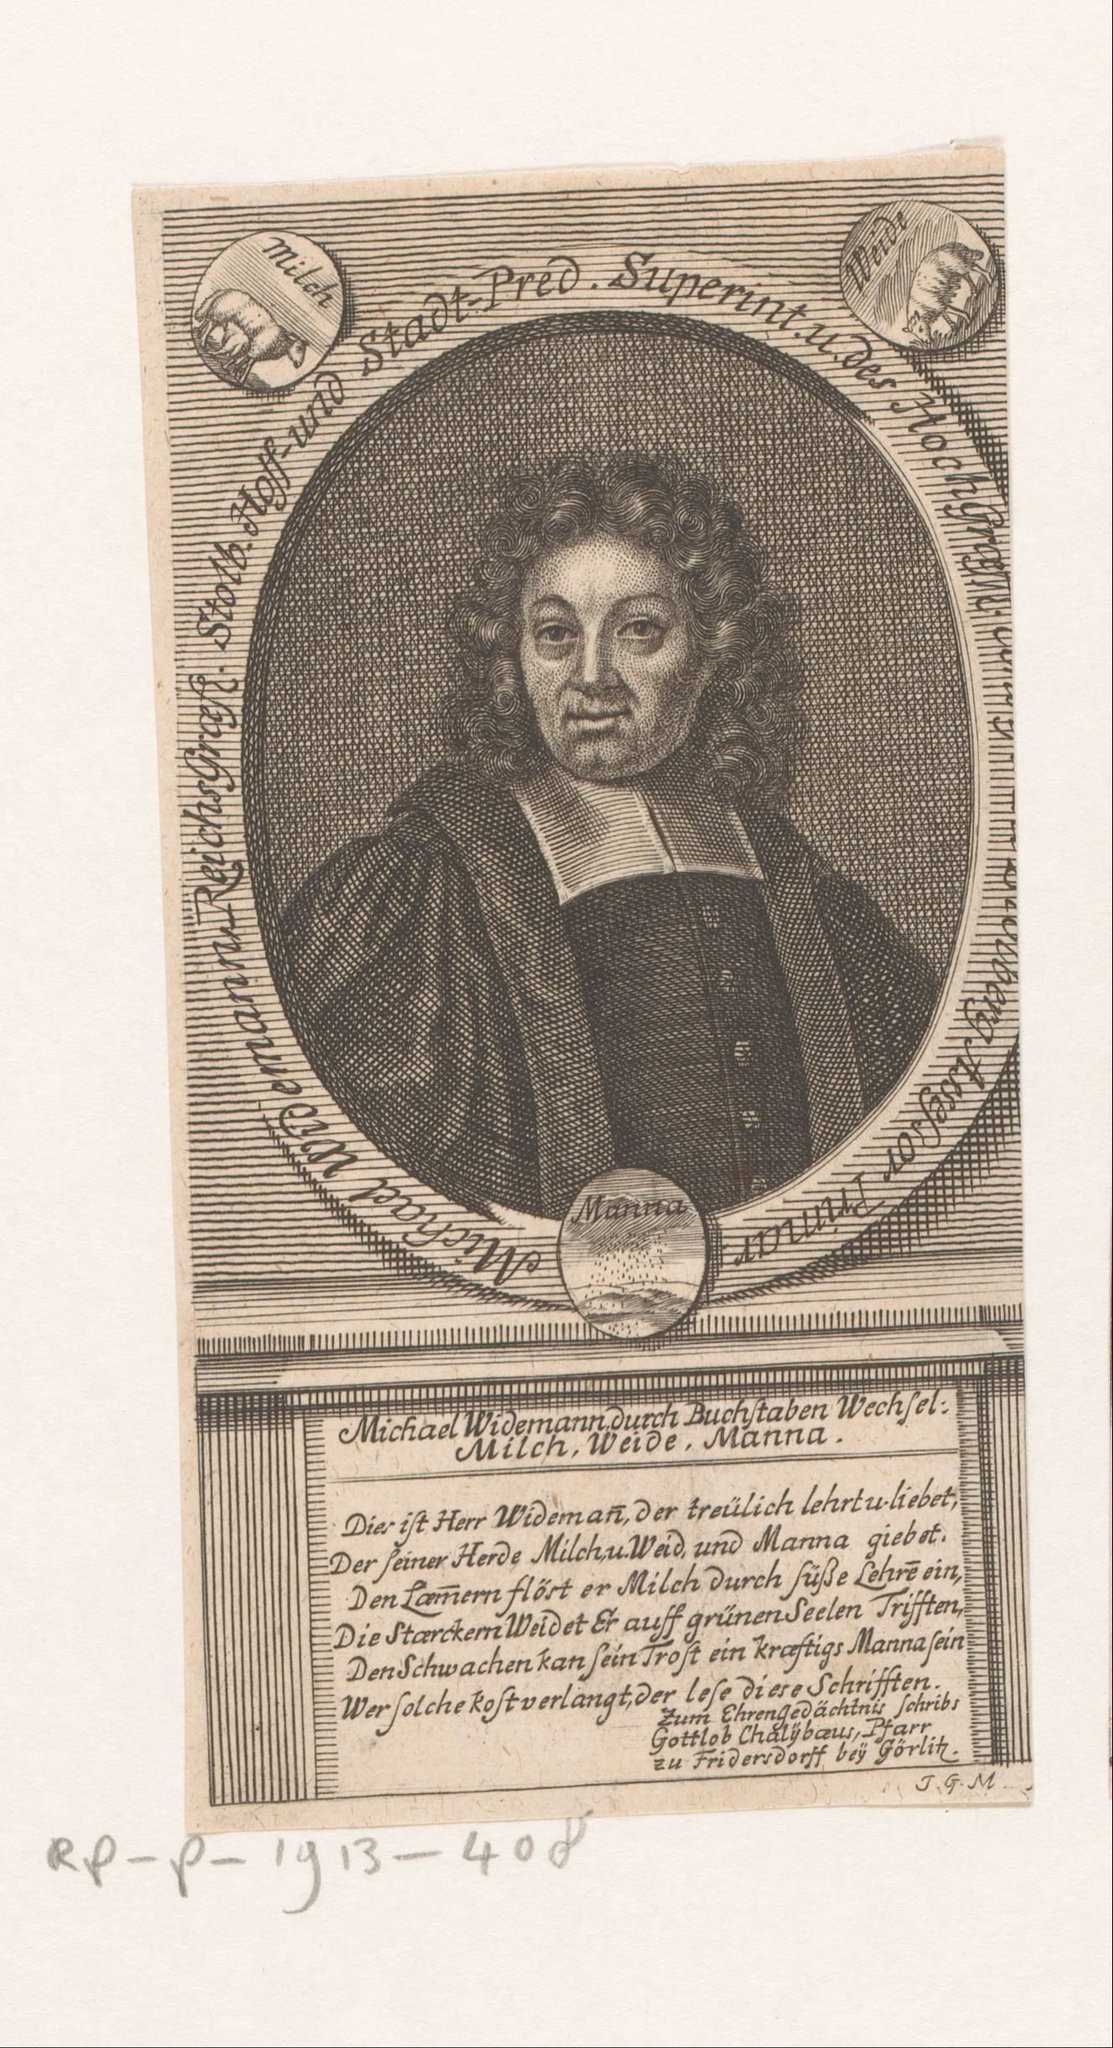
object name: print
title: Portret van Michael Wiedemann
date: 1687-1743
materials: paper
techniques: engraving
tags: theologian, in the morning manna falls to the earth ~ exodus, historical persons, sheep, wig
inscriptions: collector's mark: Lugt 2228